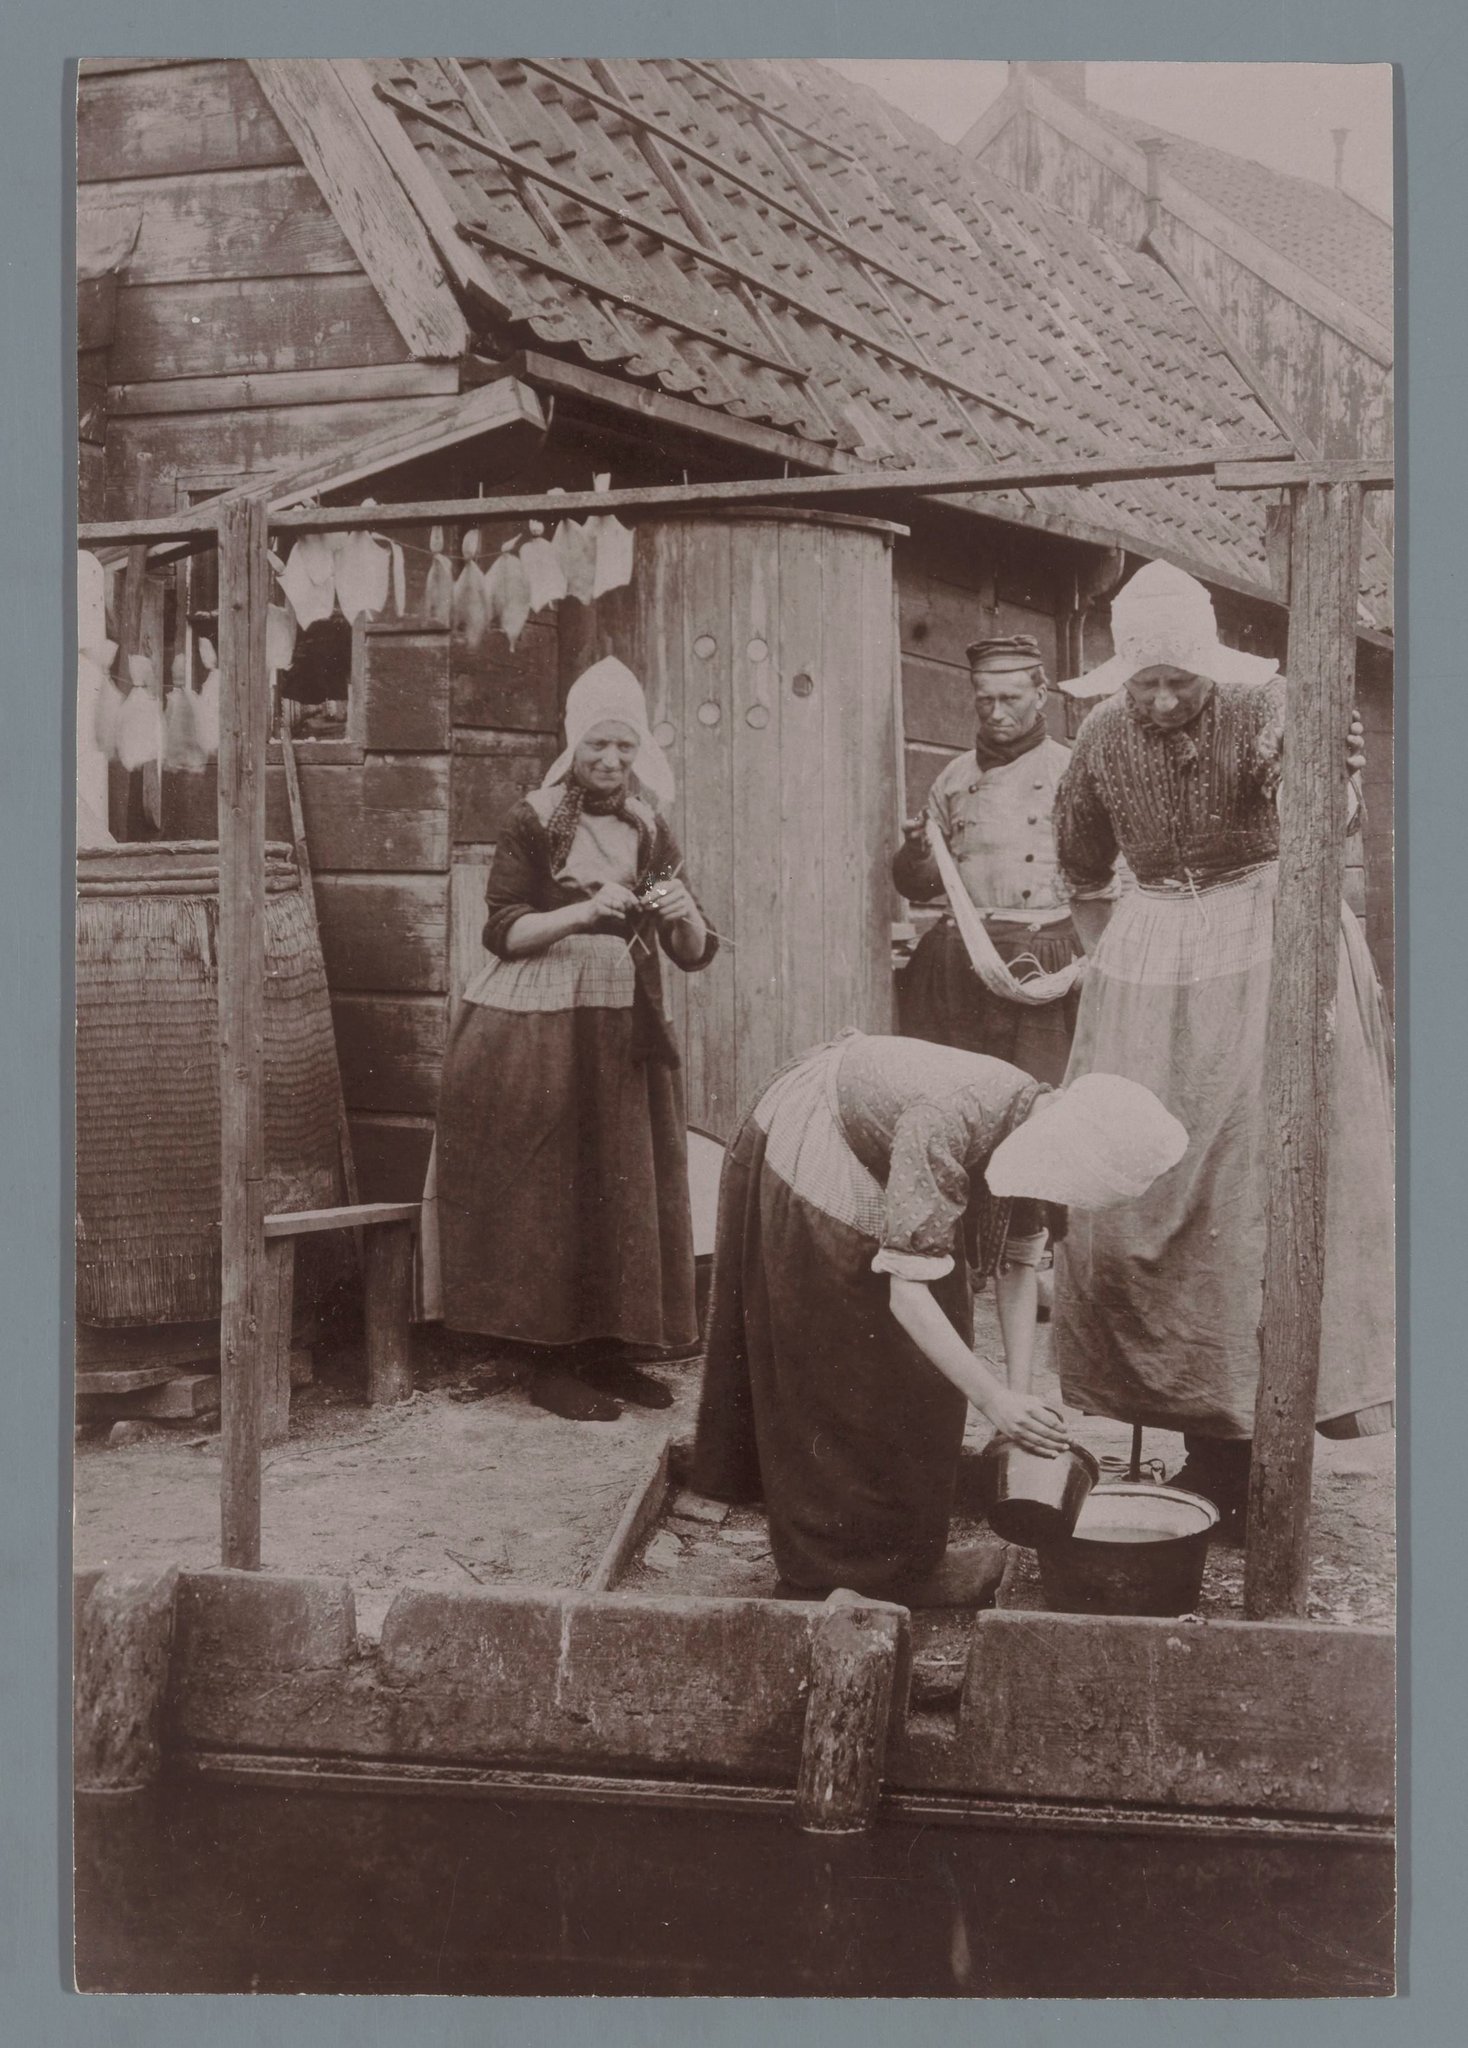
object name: photograph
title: Portret van vrouwen en een man in klederdracht te Muiden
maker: Anonymous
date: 1882-1940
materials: photographic support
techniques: gelatin silver print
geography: muiden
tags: folk costume, regional costume